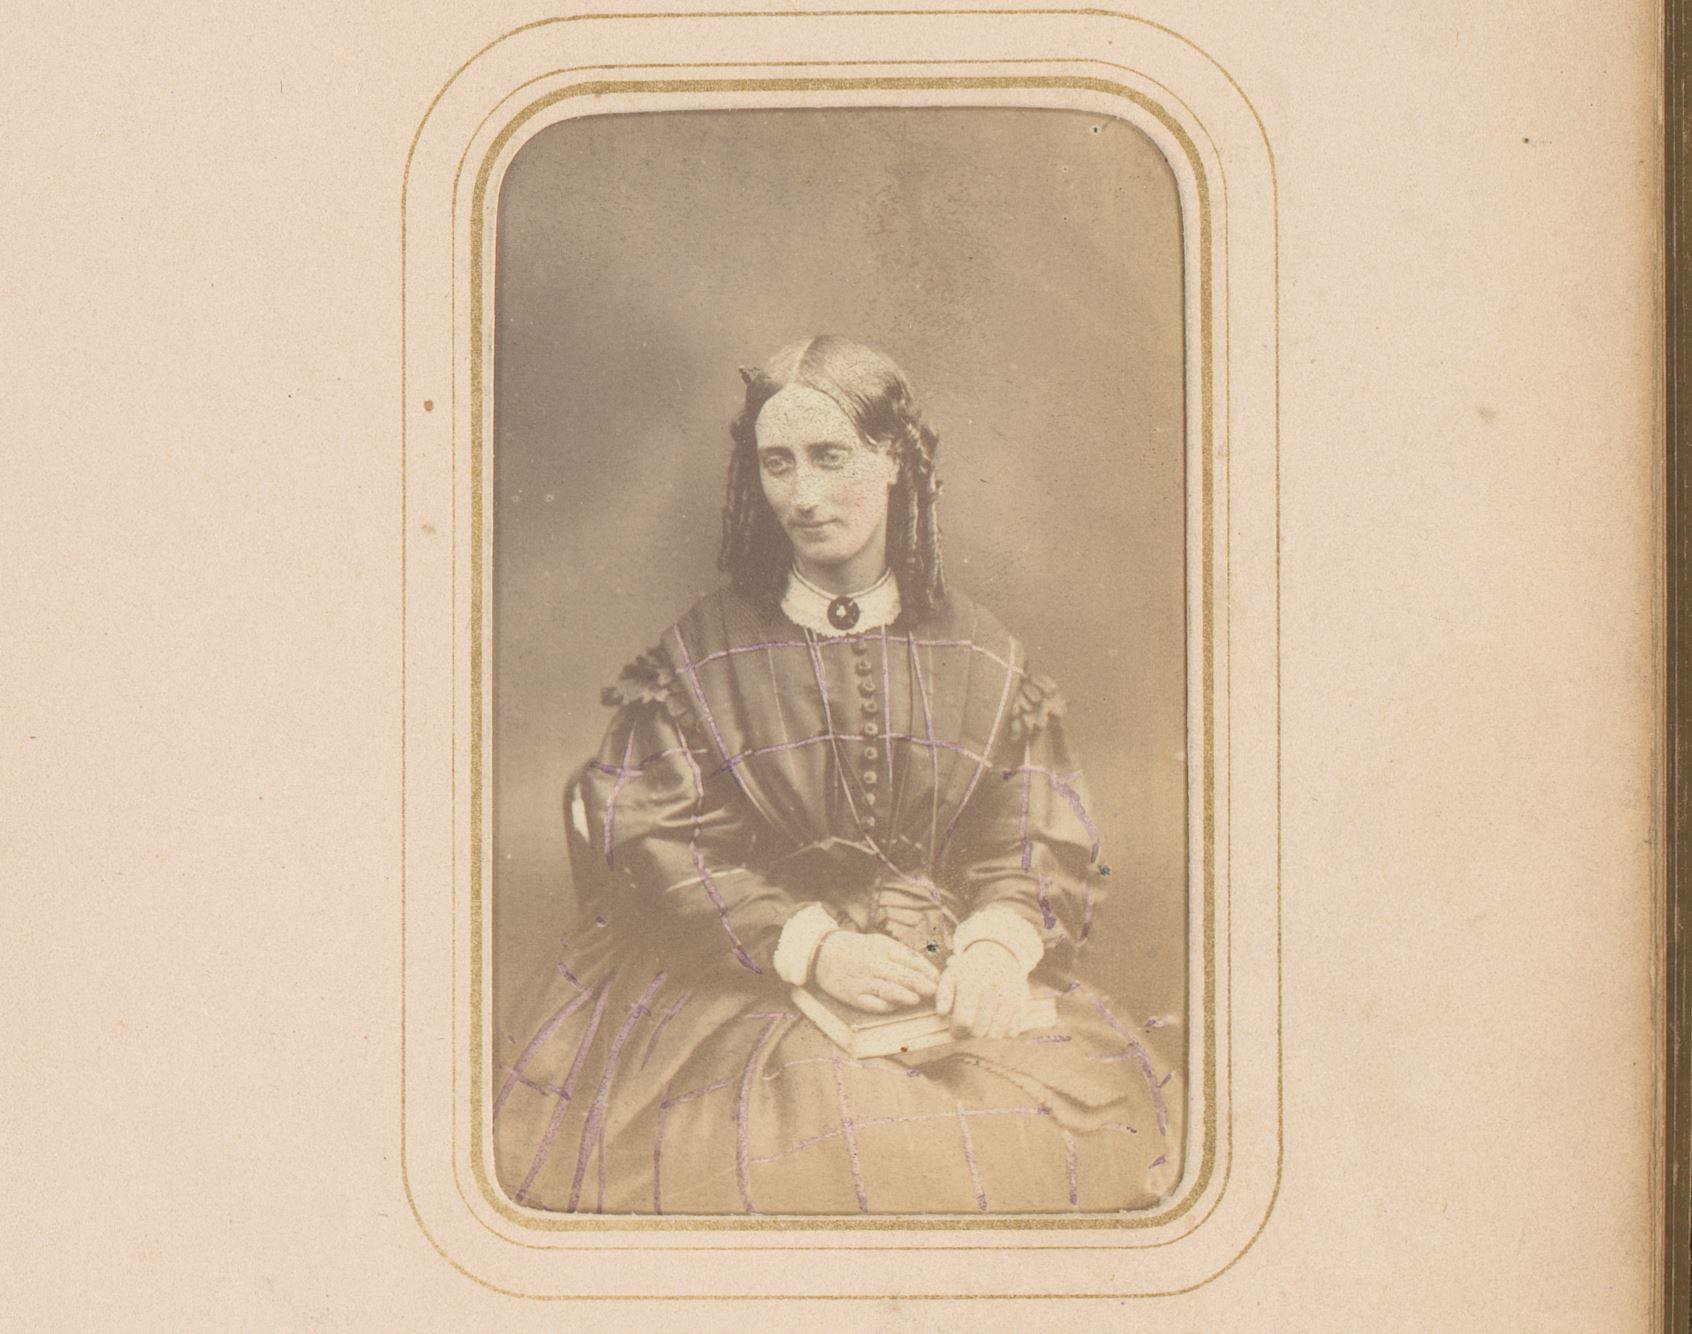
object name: photograph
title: Portret van een zittende vrouw met boek op schoot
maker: Anonymous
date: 1860-1900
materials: cardboard, photographic support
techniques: albumen print, hand coloring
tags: sitting figure - aa - female human figure, historical persons - bb - woman, book